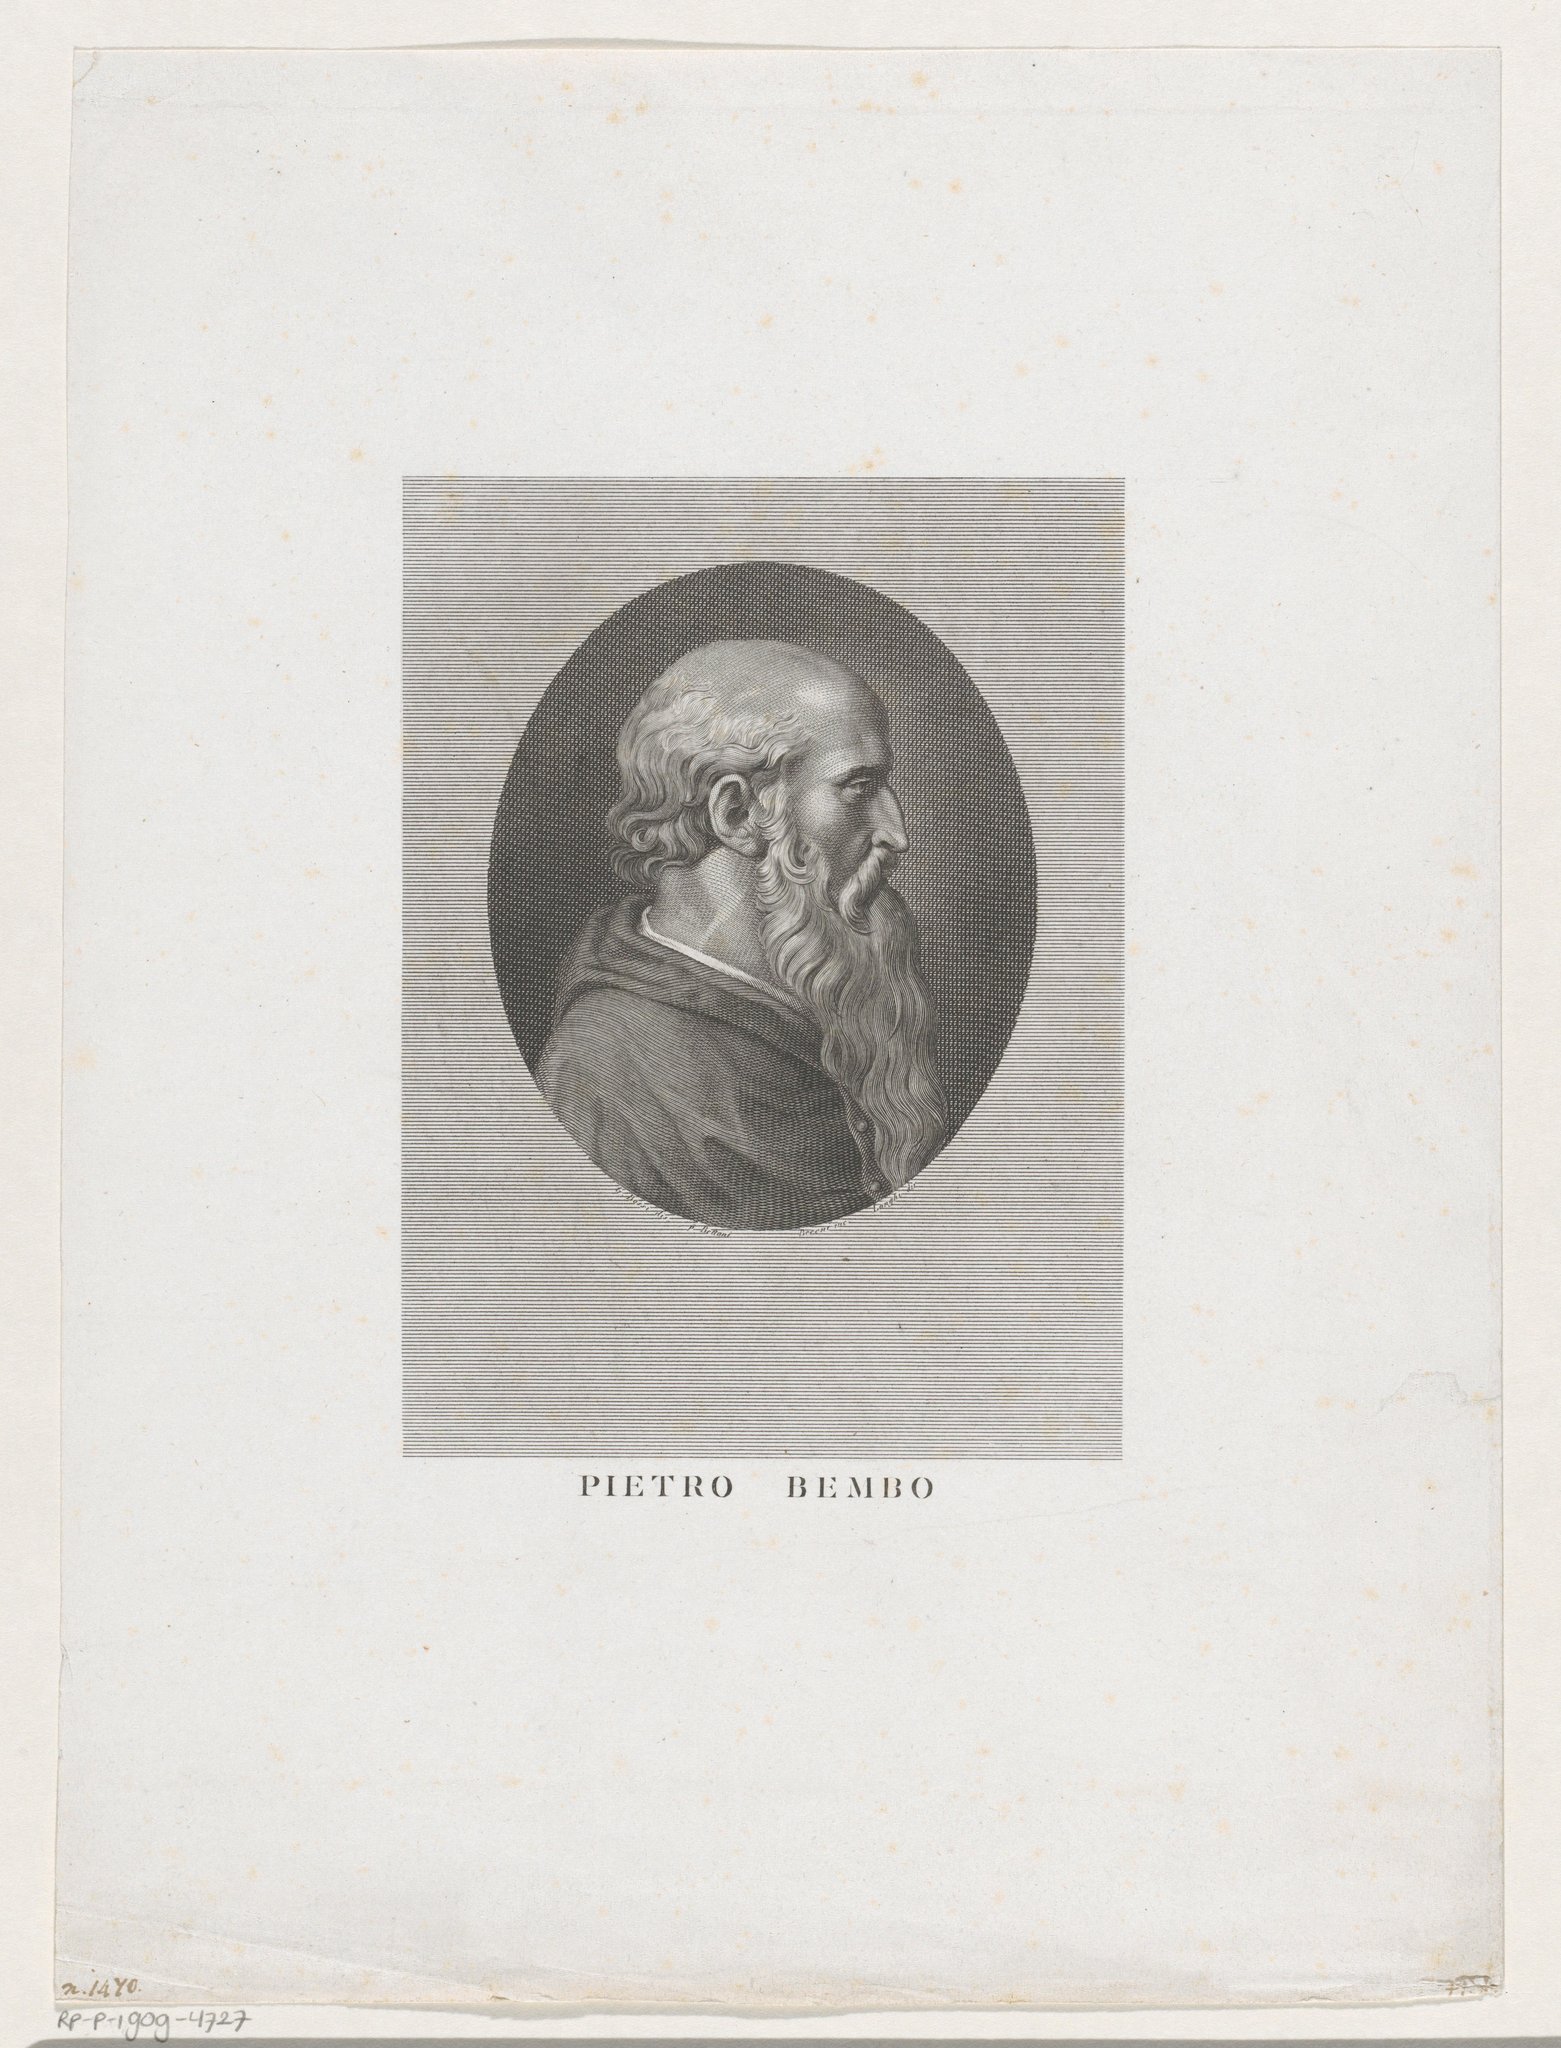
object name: print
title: Portret van Pietro Bembo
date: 1765-1829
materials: paper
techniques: engraving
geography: italy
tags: venice, historical persons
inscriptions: collector's mark: Lugt 2228, number: ‘n. 1470.’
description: Deze prent maakt deel uit van een reeks portretprenten van onbekende omvang. De reeks is in meerdere staten uitgegeven. De eerste staat met enkel het portret in ovaal. Een tweede staat met naam van de geportretteerde in holle letters onder de voorstelling. Een derde staat met de naam van de geportretteerde in gevulde letters onder de voorstelling. En een vierde staat met een rechthoekig kader rondom het ovale portret.